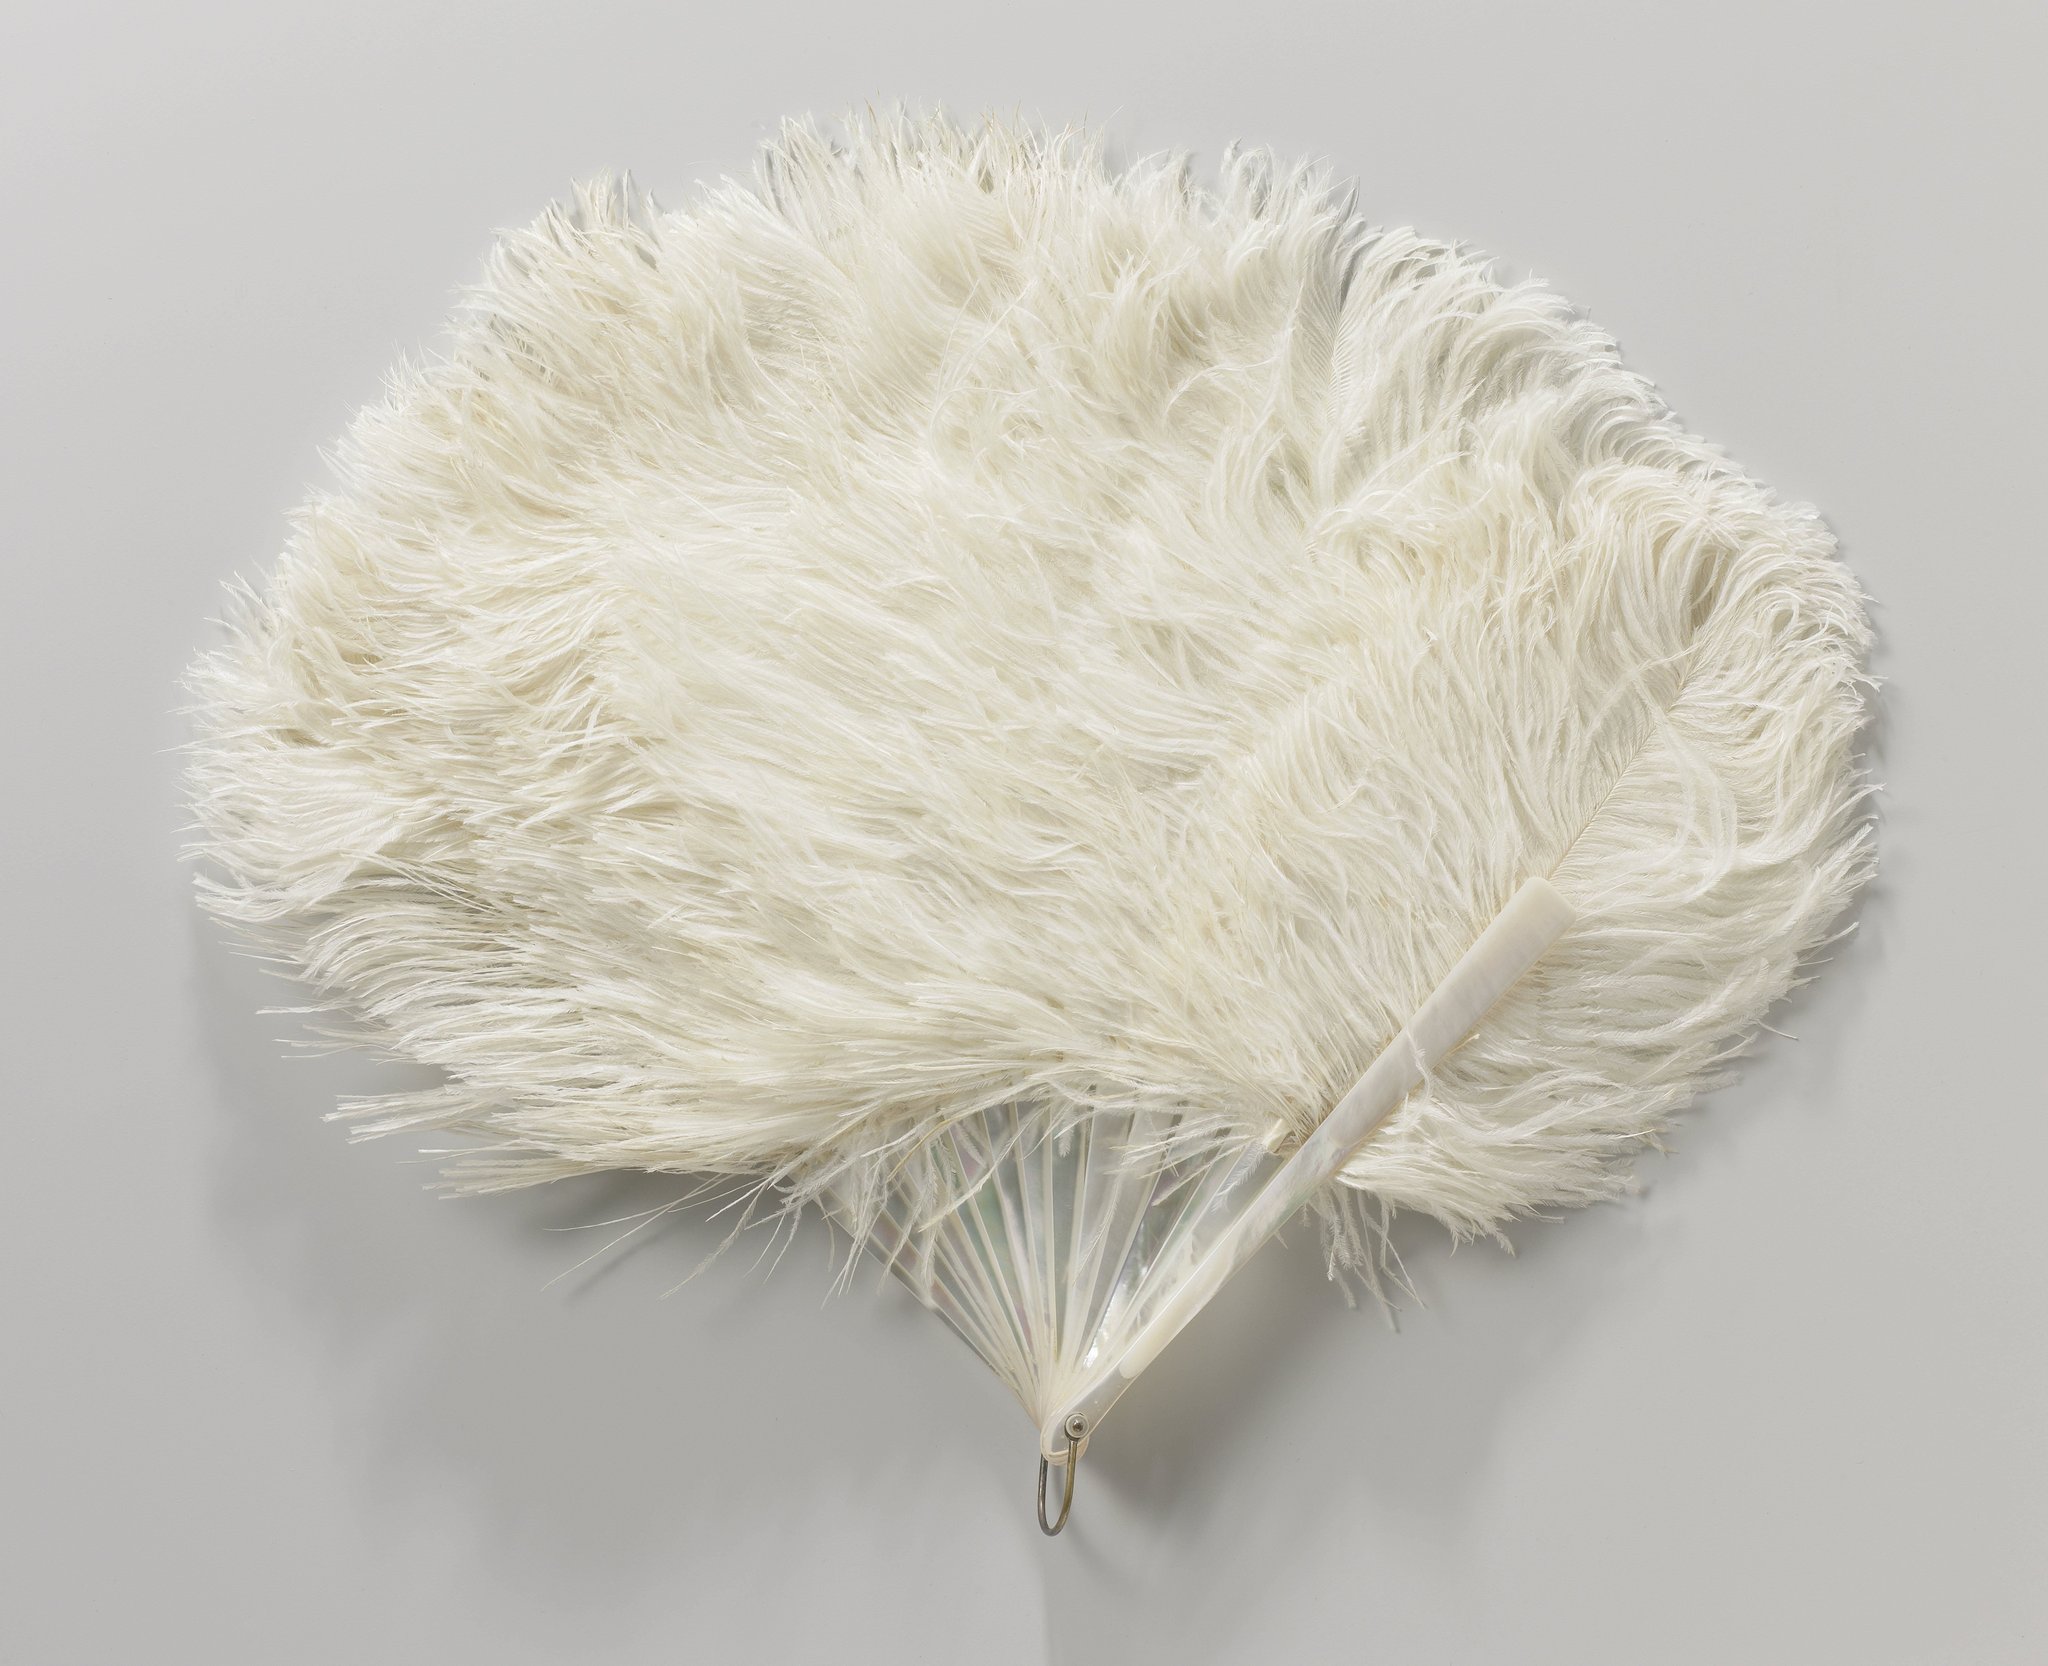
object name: vouwwaaier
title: Vouwwaaier van witte struisveren op een gesloten, onbewerkte parelmoeren montuur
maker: Anonymous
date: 1900-1925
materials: metal, mother of pearl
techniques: cutting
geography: netherlands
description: Vouwwaaier van witte struisveren op een gesloten, onbewerkte parelmoeren montuur. Het montuur telt 16 aaneengesloten benen, waaraan een metalen waaierring en een parelmoeren schijfje bij de sluitpin.